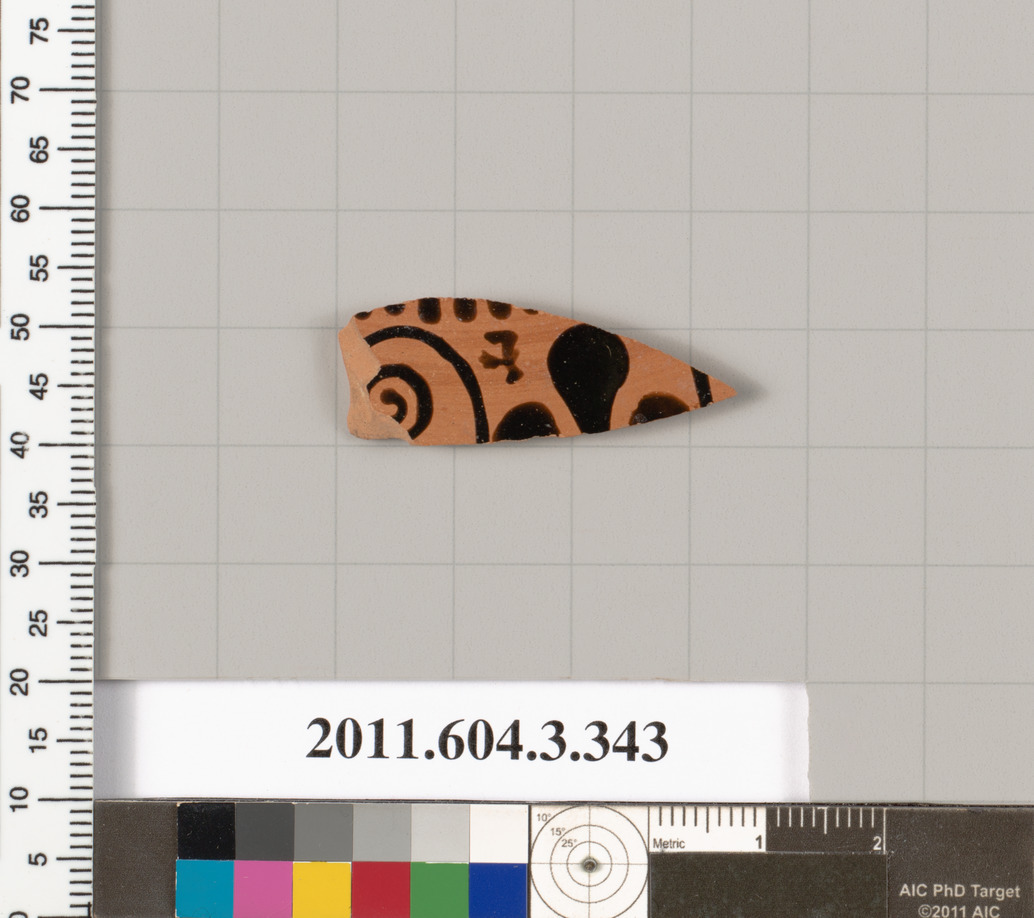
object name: neck amphora fragment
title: Terracotta fragment of a neck-amphora (jar)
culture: greek, attic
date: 525-501 BCE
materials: terracotta